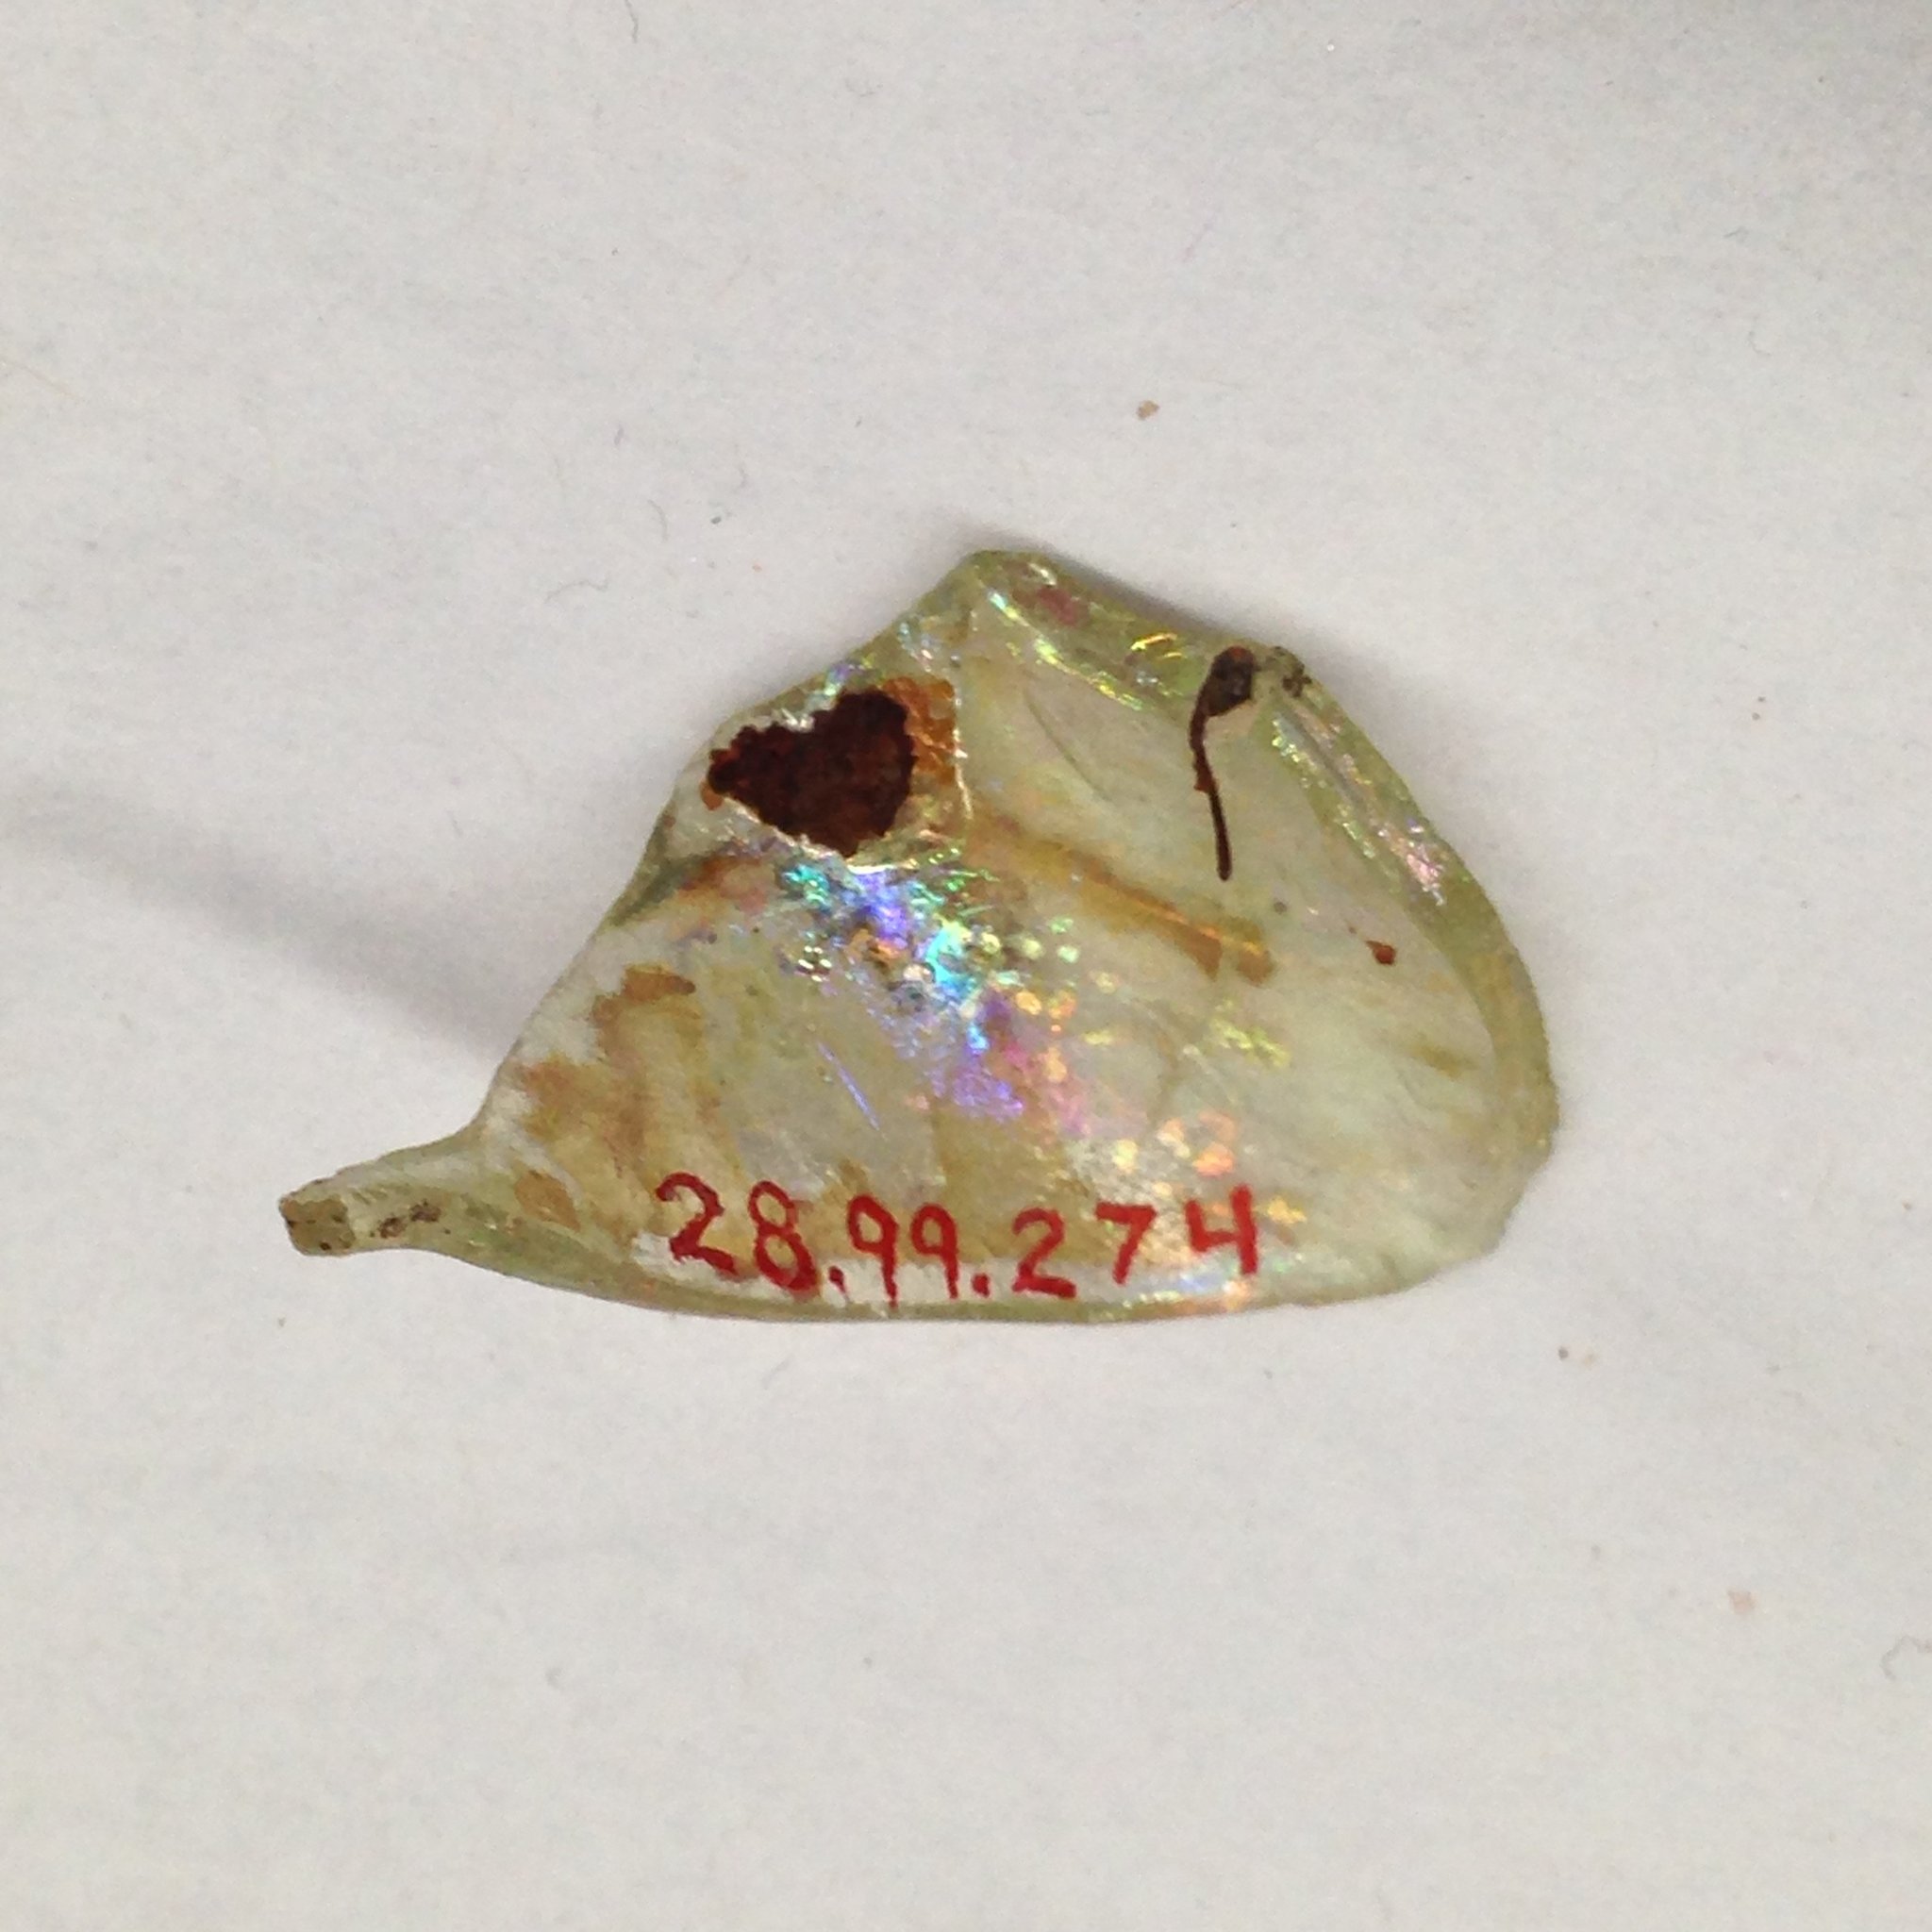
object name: fragment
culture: european or middle eastern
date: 1150-1250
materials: ceramic, glass